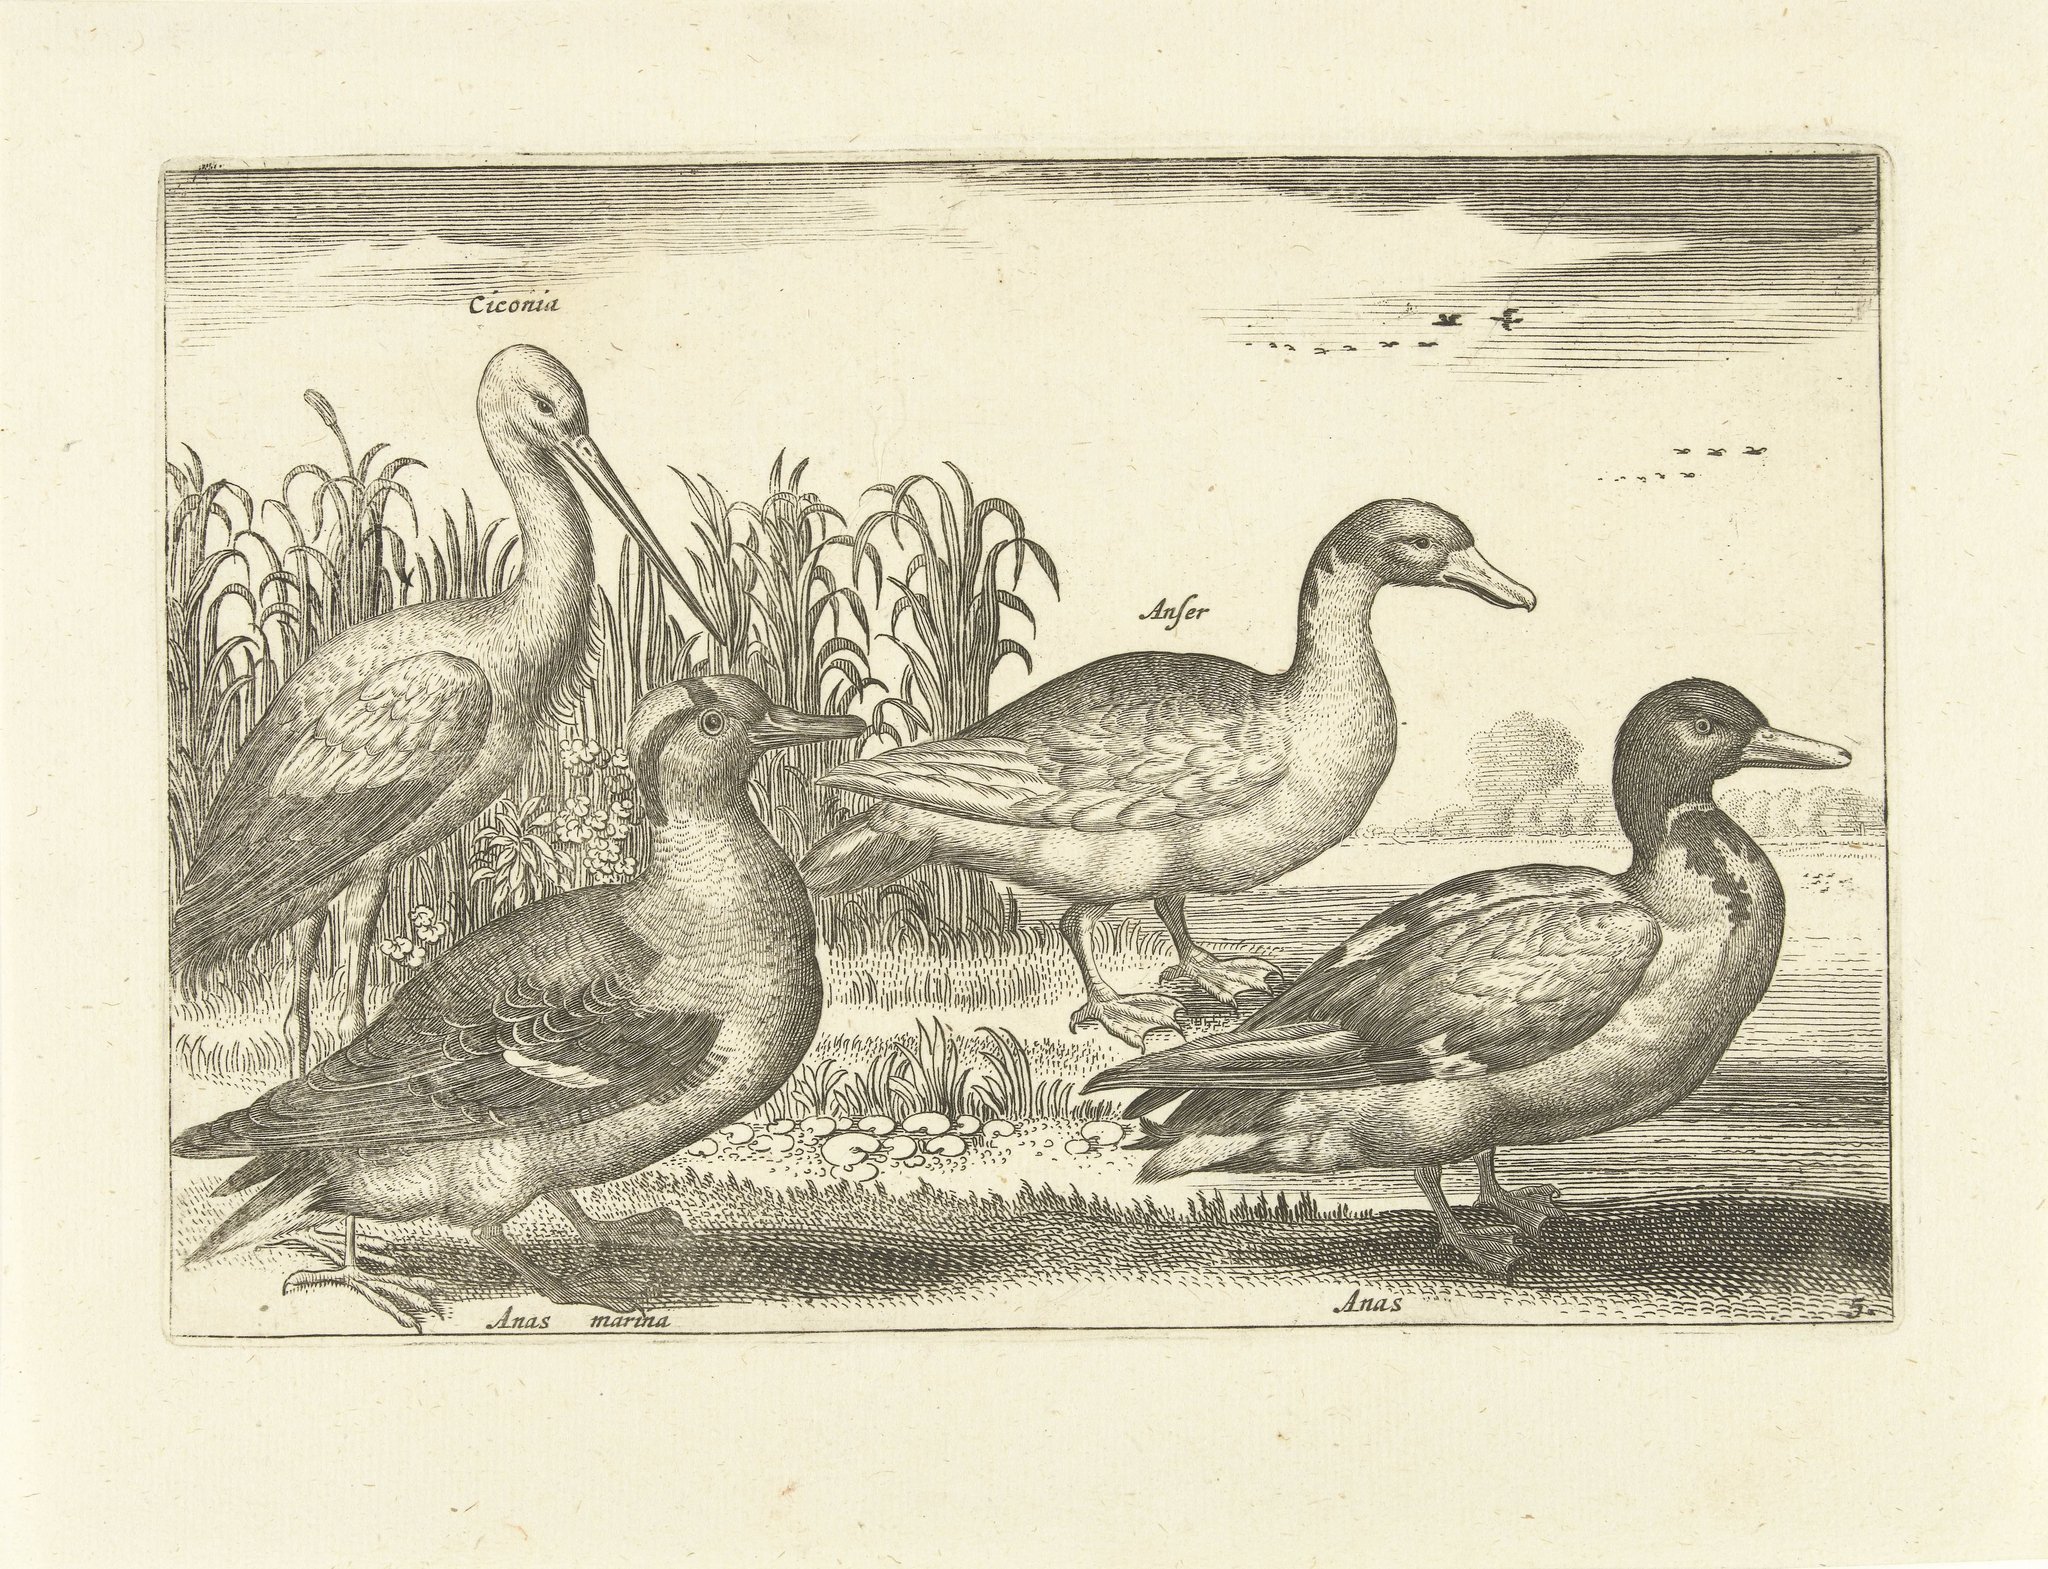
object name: print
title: Vogels in het riet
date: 1659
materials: paper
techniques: engraving, etching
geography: antwerp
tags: shore-birds and wading-birds: stork, water-birds: duck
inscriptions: collector's mark: Lugt 2228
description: Drie eenden en een ooievaar in het riet. De prent maakt deel uit van een serie met vogels als onderwerp.